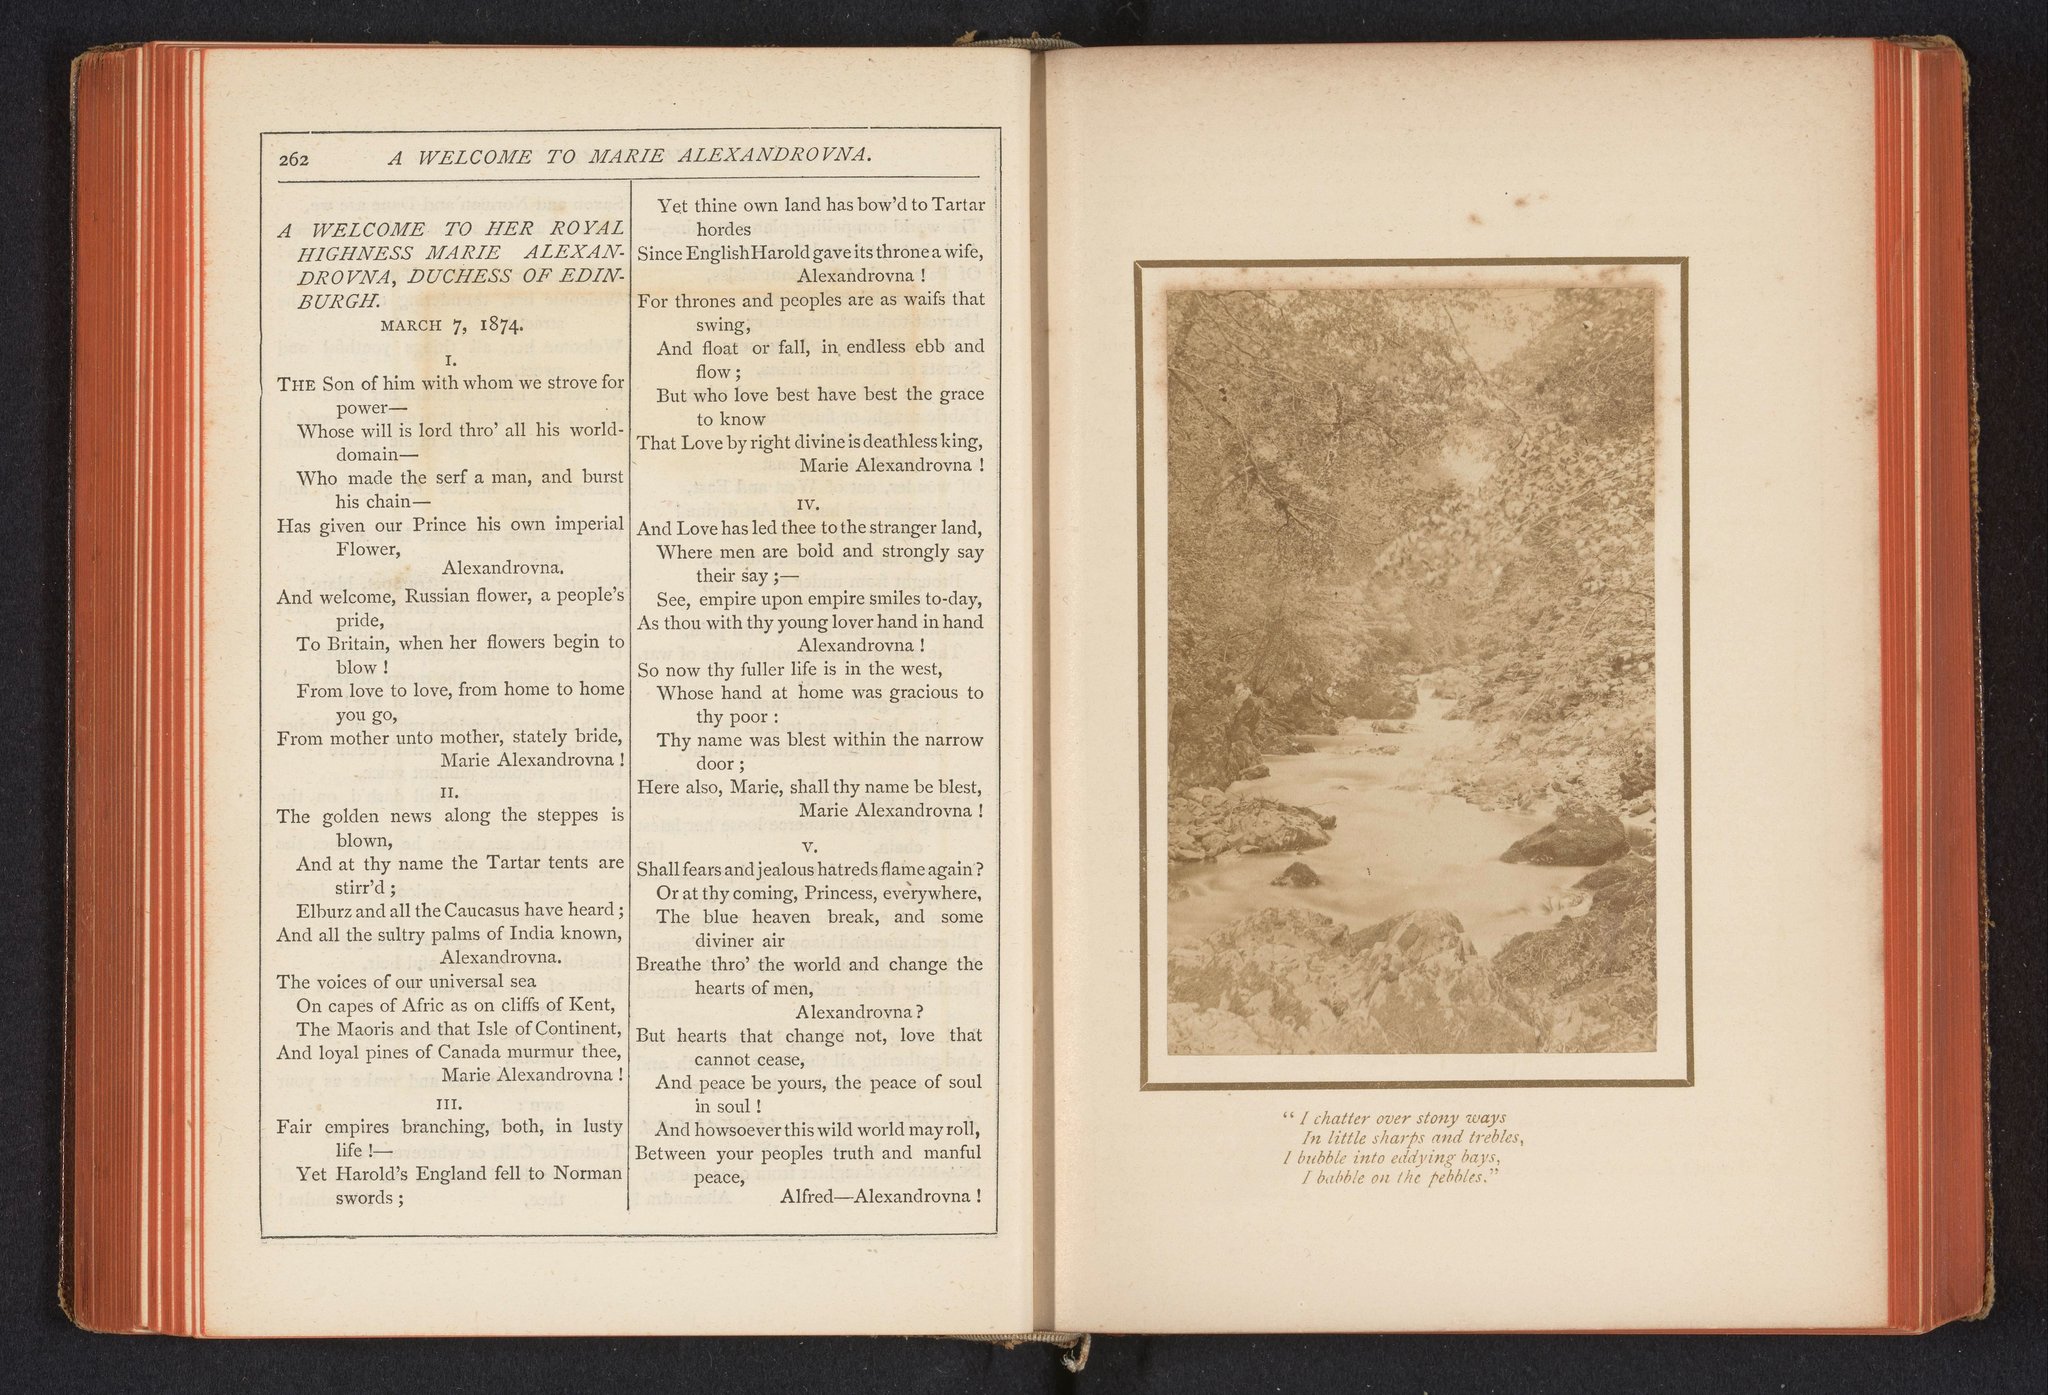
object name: photograph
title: Rivier met rotsen erin en bomen op de oever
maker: john payne jennings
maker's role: fotograaf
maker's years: 1843-1926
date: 1872-1882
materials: photographic support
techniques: albumen print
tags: river, rock-formations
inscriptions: inscription: ‘“ I chatter over stony ways In little sharps and trebles, I bubble into eddying bays, i babble on the pebbles. ”’